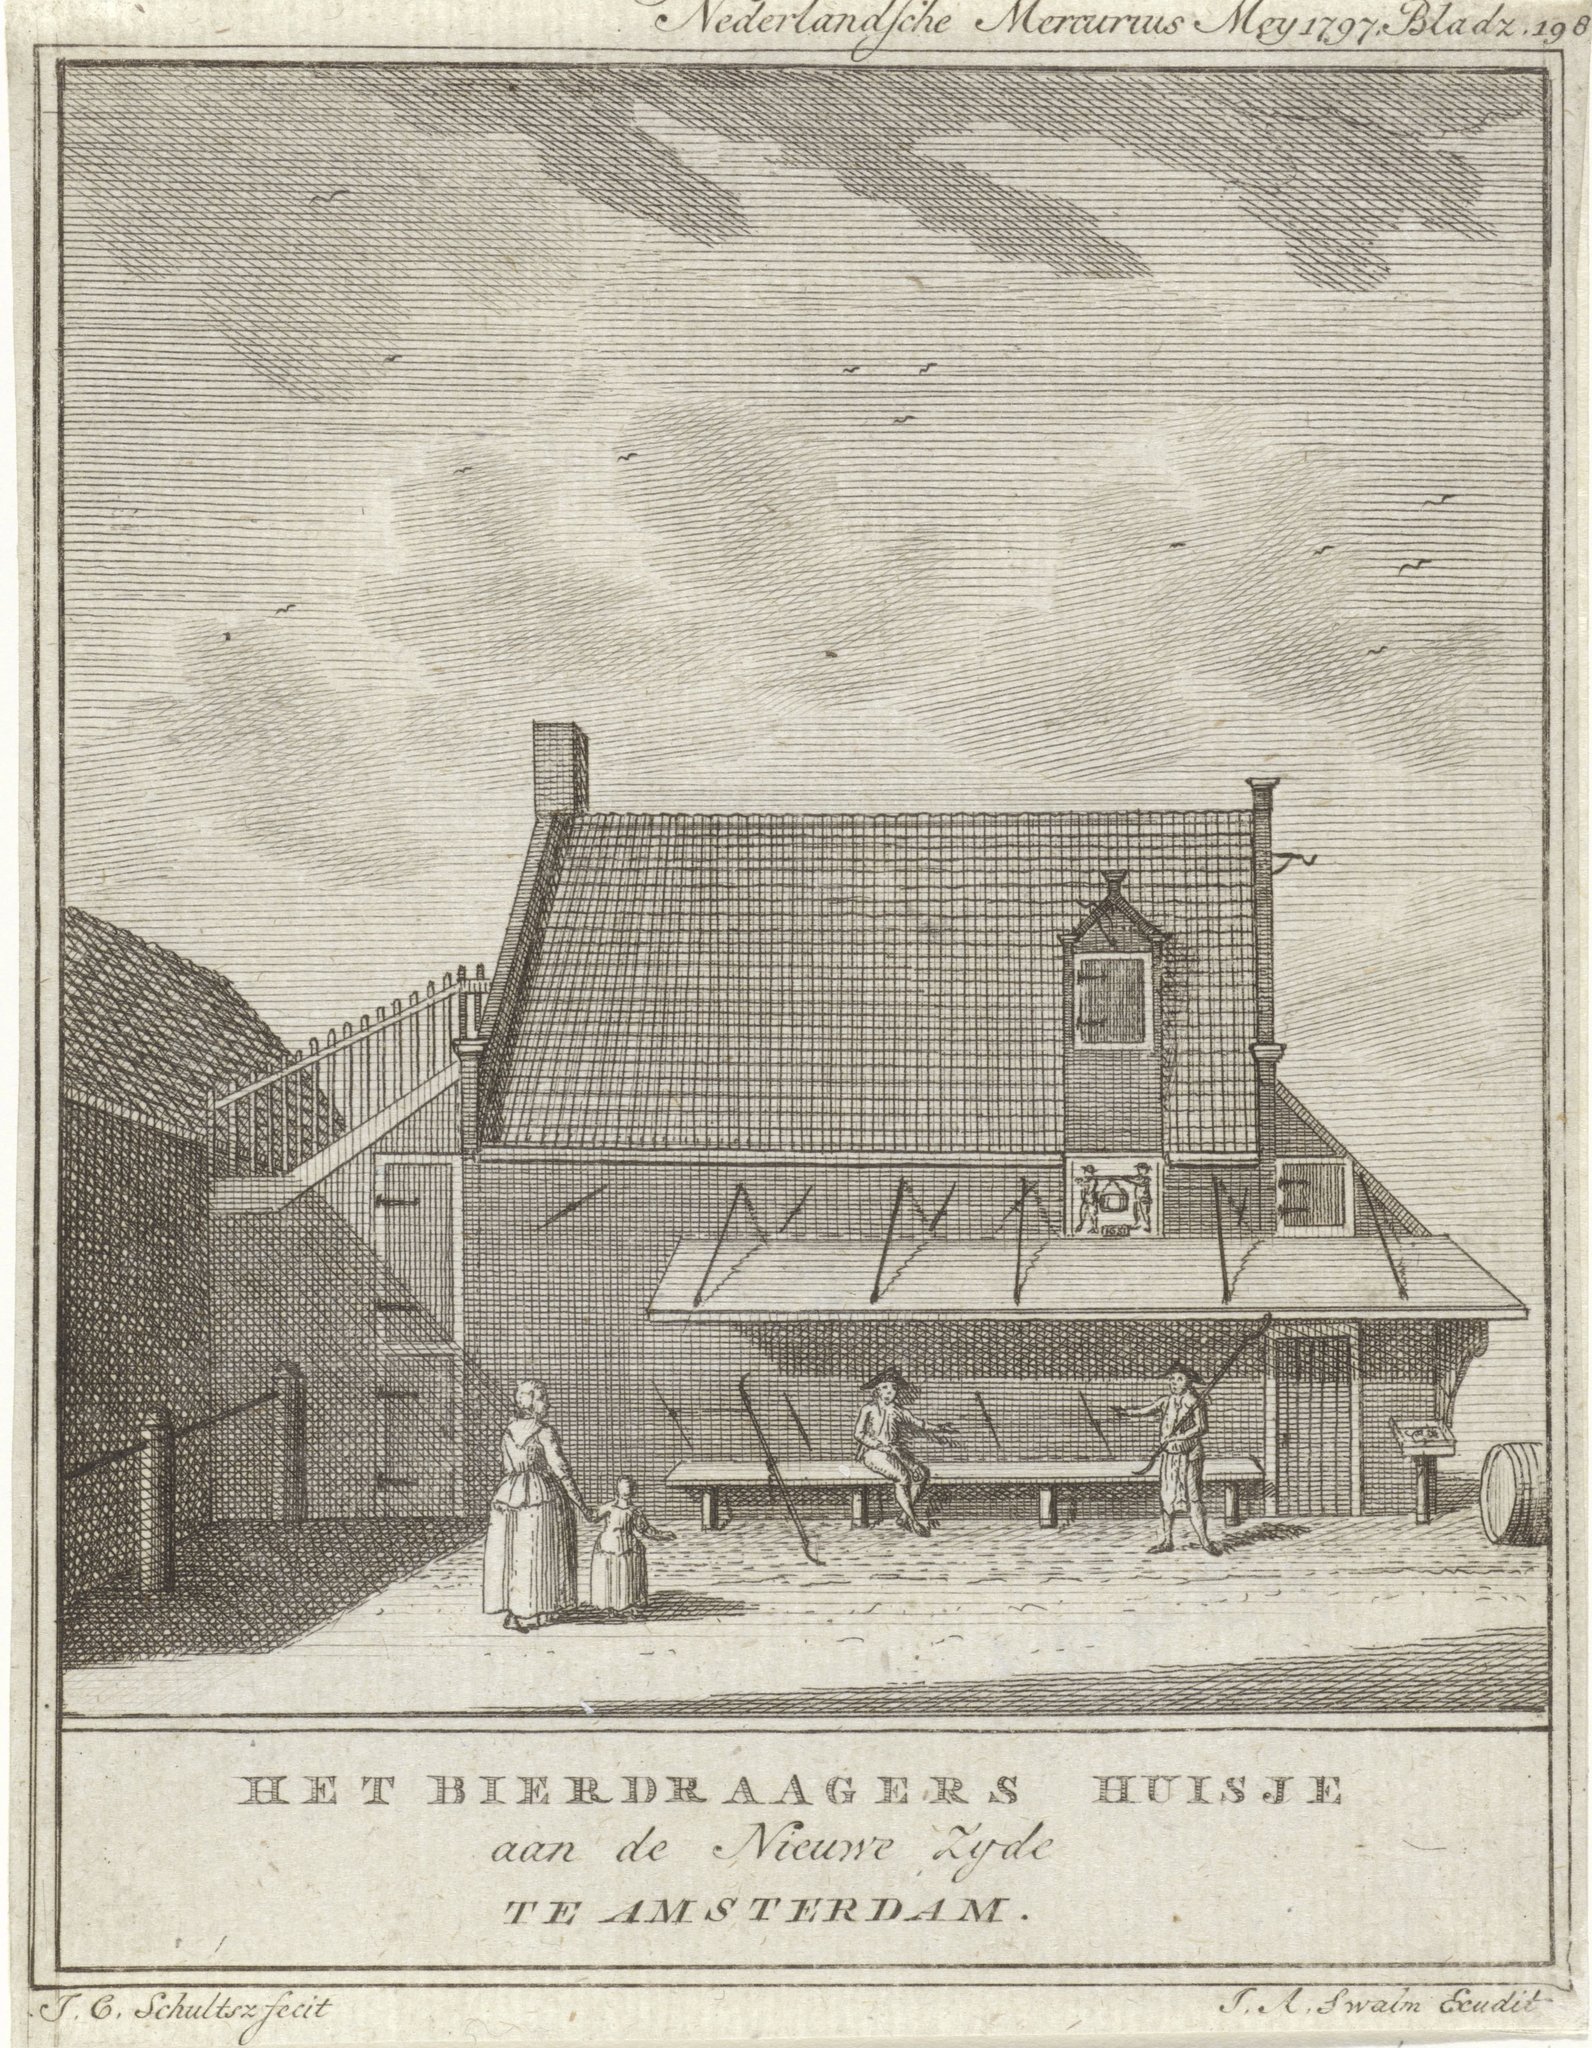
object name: print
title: Het Bierdraagers Huisje aan de Nieuwe Zyde te Amsterdam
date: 1705-1797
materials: paper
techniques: engraving, etching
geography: amsterdam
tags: guildhall, amsterdam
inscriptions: collector's mark: Lugt 2228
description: Prent uit: De maandelykse Nederlandsche Mercurius, geevende een volledig bericht van alles, wat'er aanmerkenswaardig ieder maand, in Europa is voorgevallen. Amsterdam: J.A. Swalm, 1797.